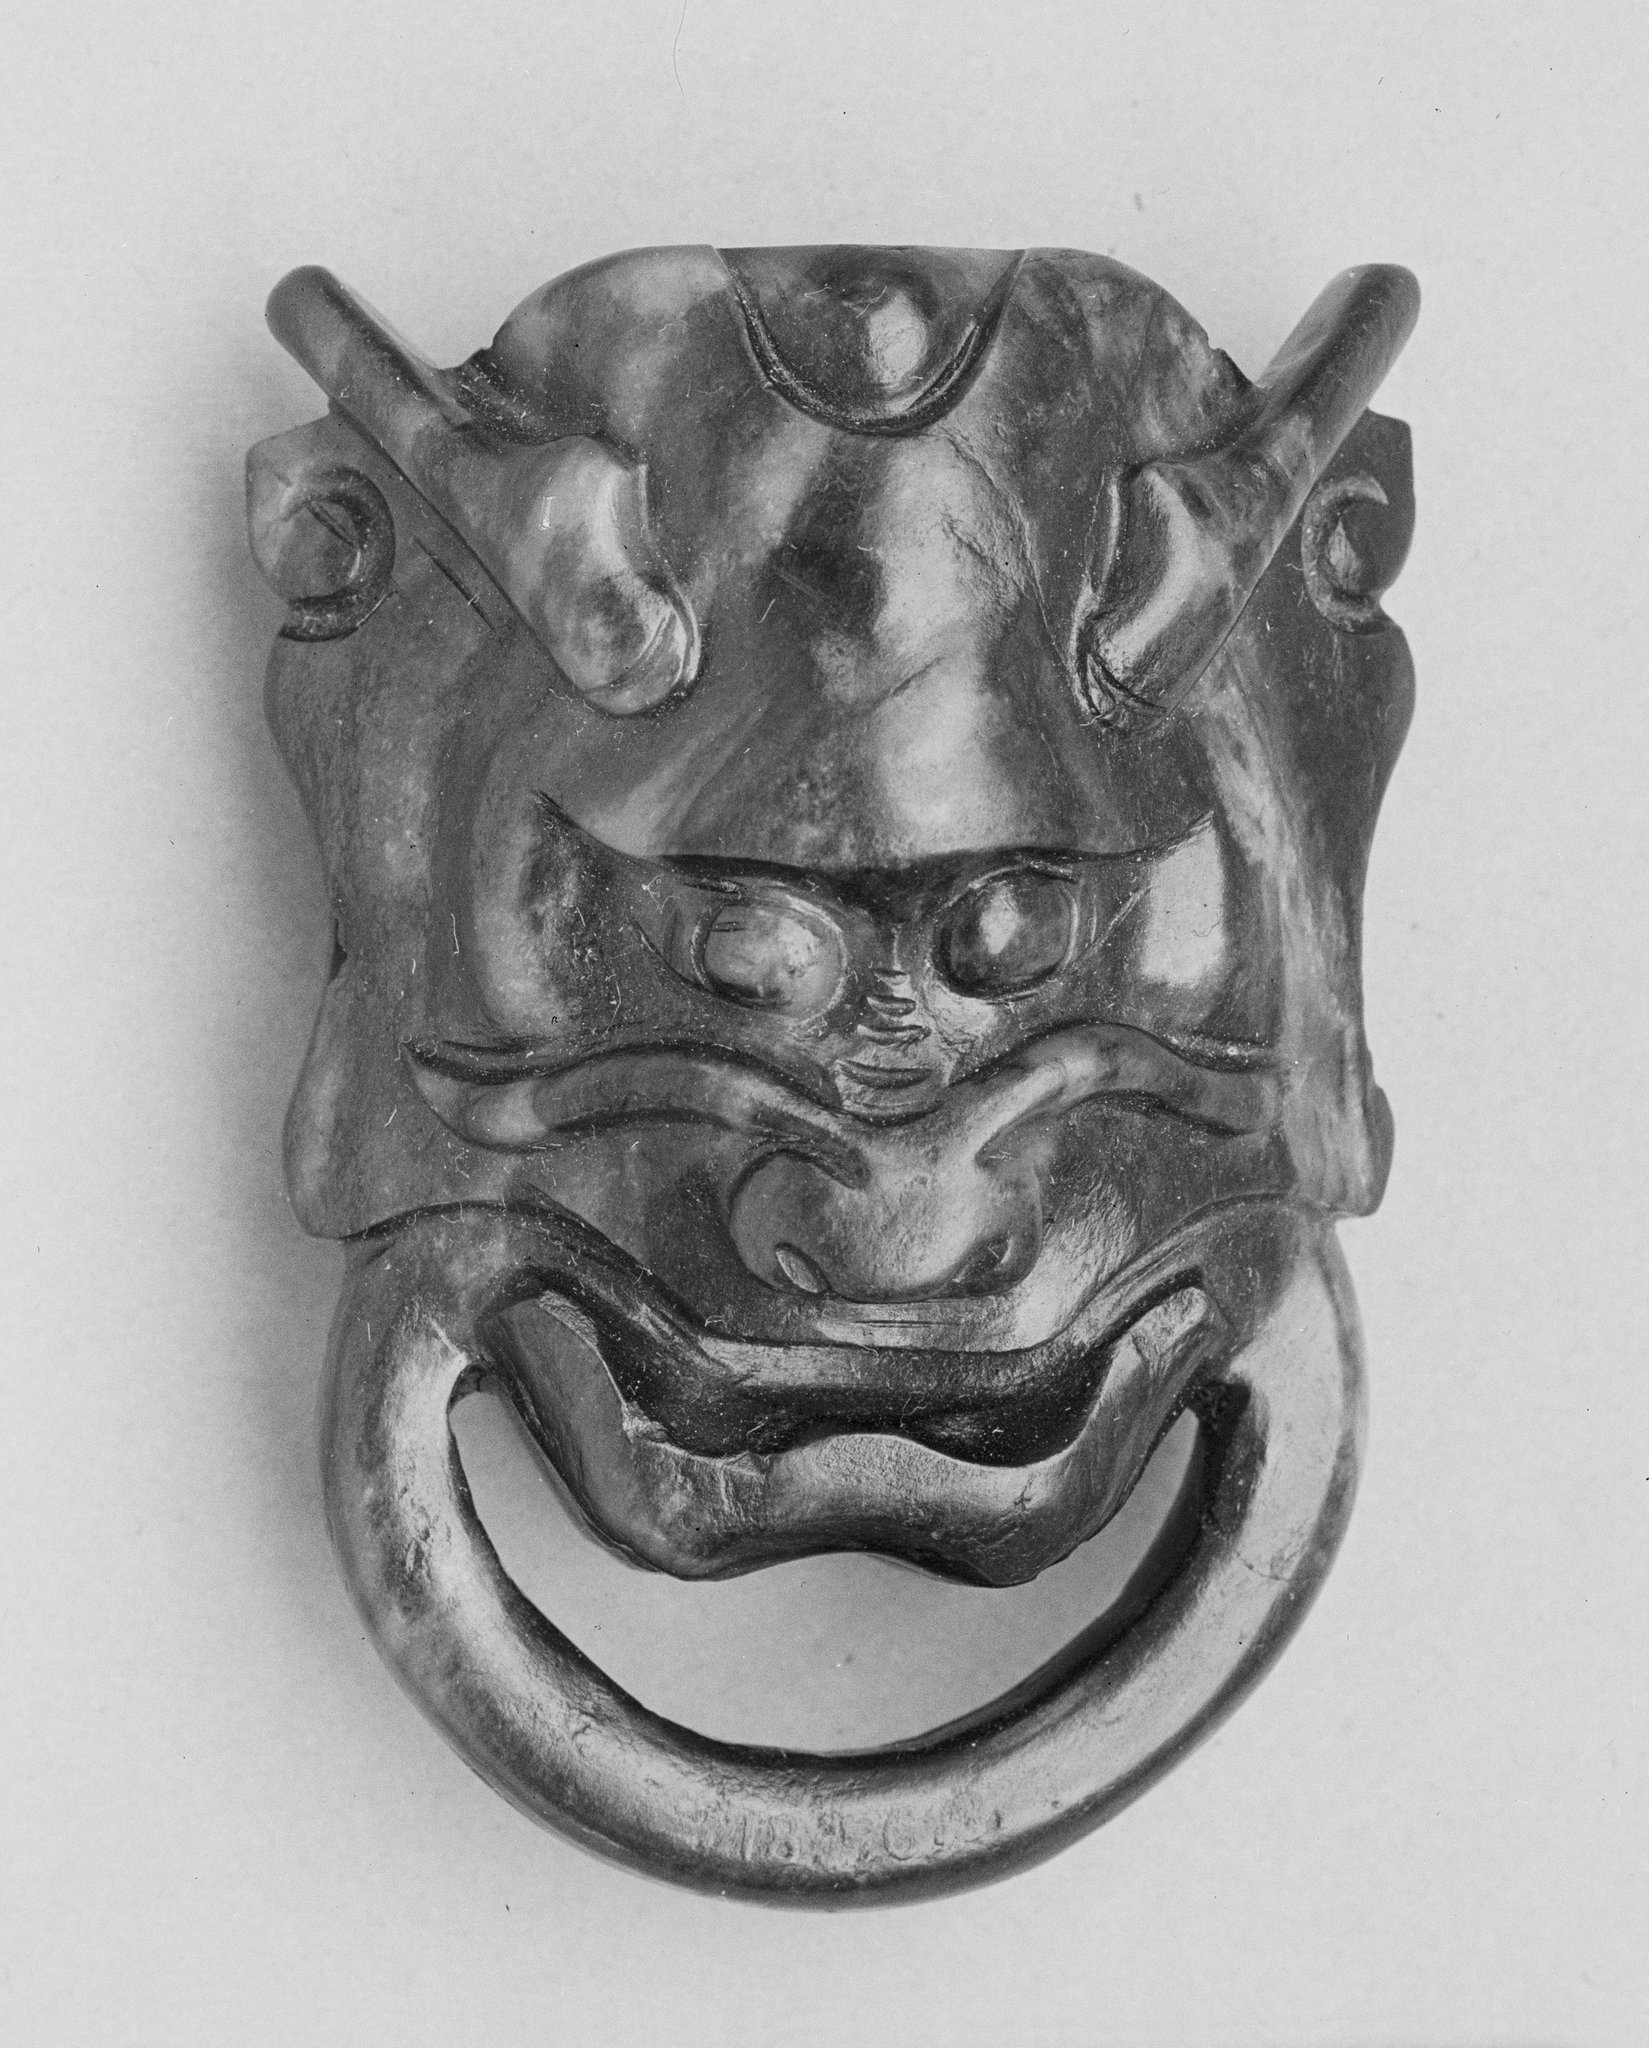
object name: mask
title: Mask of a Demon Holding a Ring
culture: chinese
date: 206 BCE-220 CE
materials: jade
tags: masks,demons